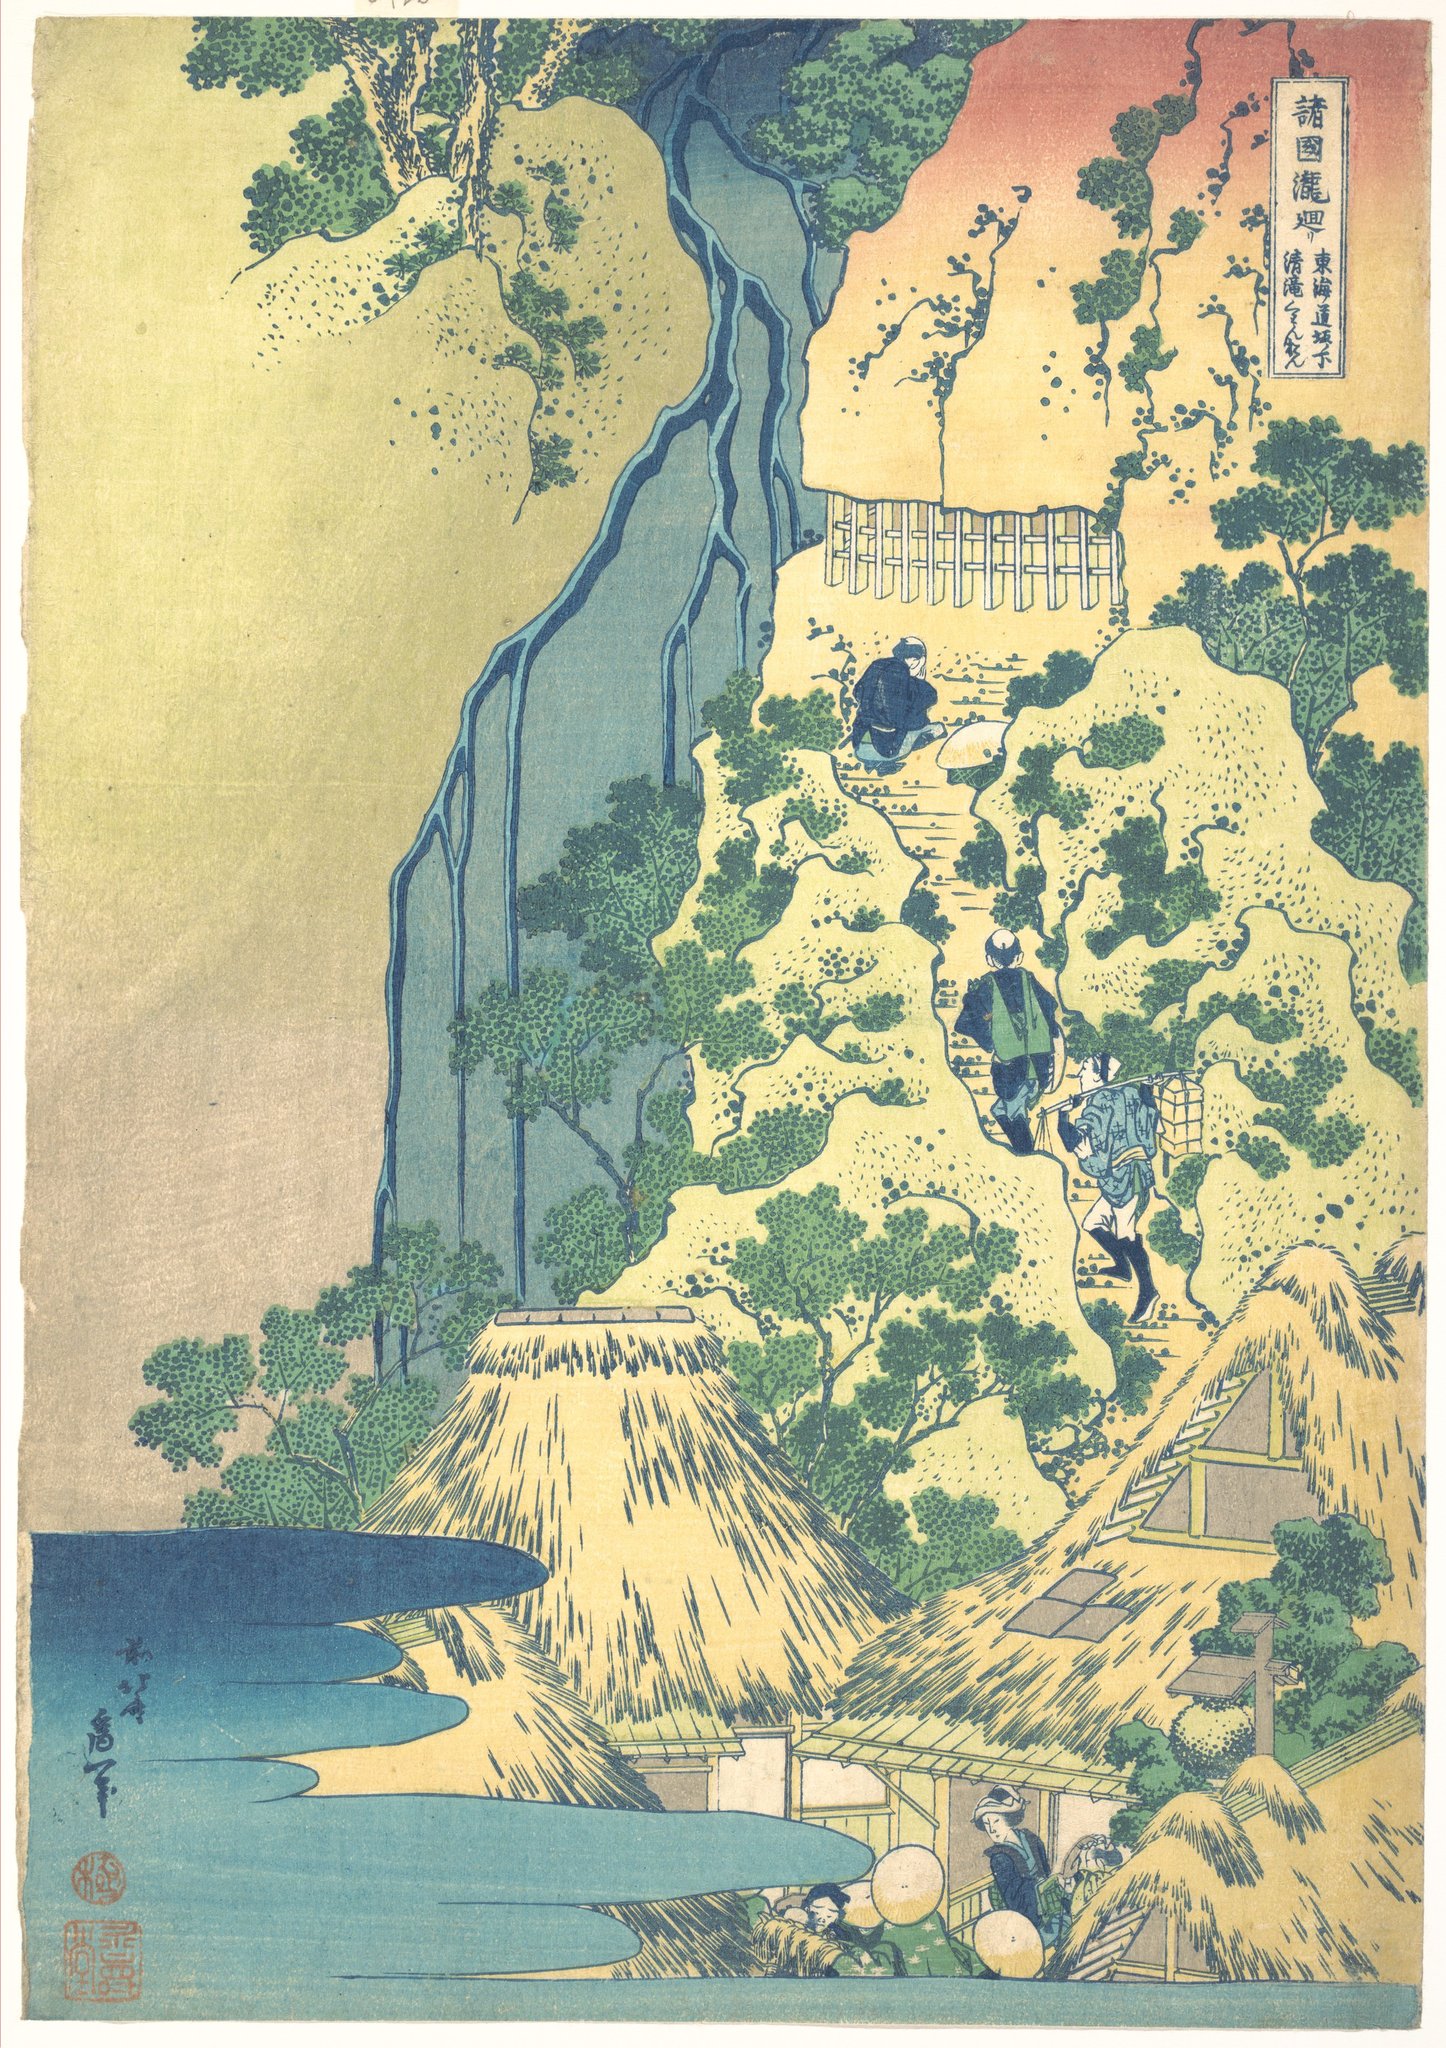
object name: woodblock print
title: Kiyotaki Kannon Waterfall at Sakanoshita on the Tōkaidō (Tōkaidō Sakanoshita Kiyotaki kannon), from the series A Tour of Waterfalls in Various Provinces (Shokoku taki meguri)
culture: japanese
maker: katsushika hokusai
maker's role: artist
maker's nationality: japanese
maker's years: 1760-1849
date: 1832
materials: ink, paper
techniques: woodblock print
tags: waterfalls,tea houses